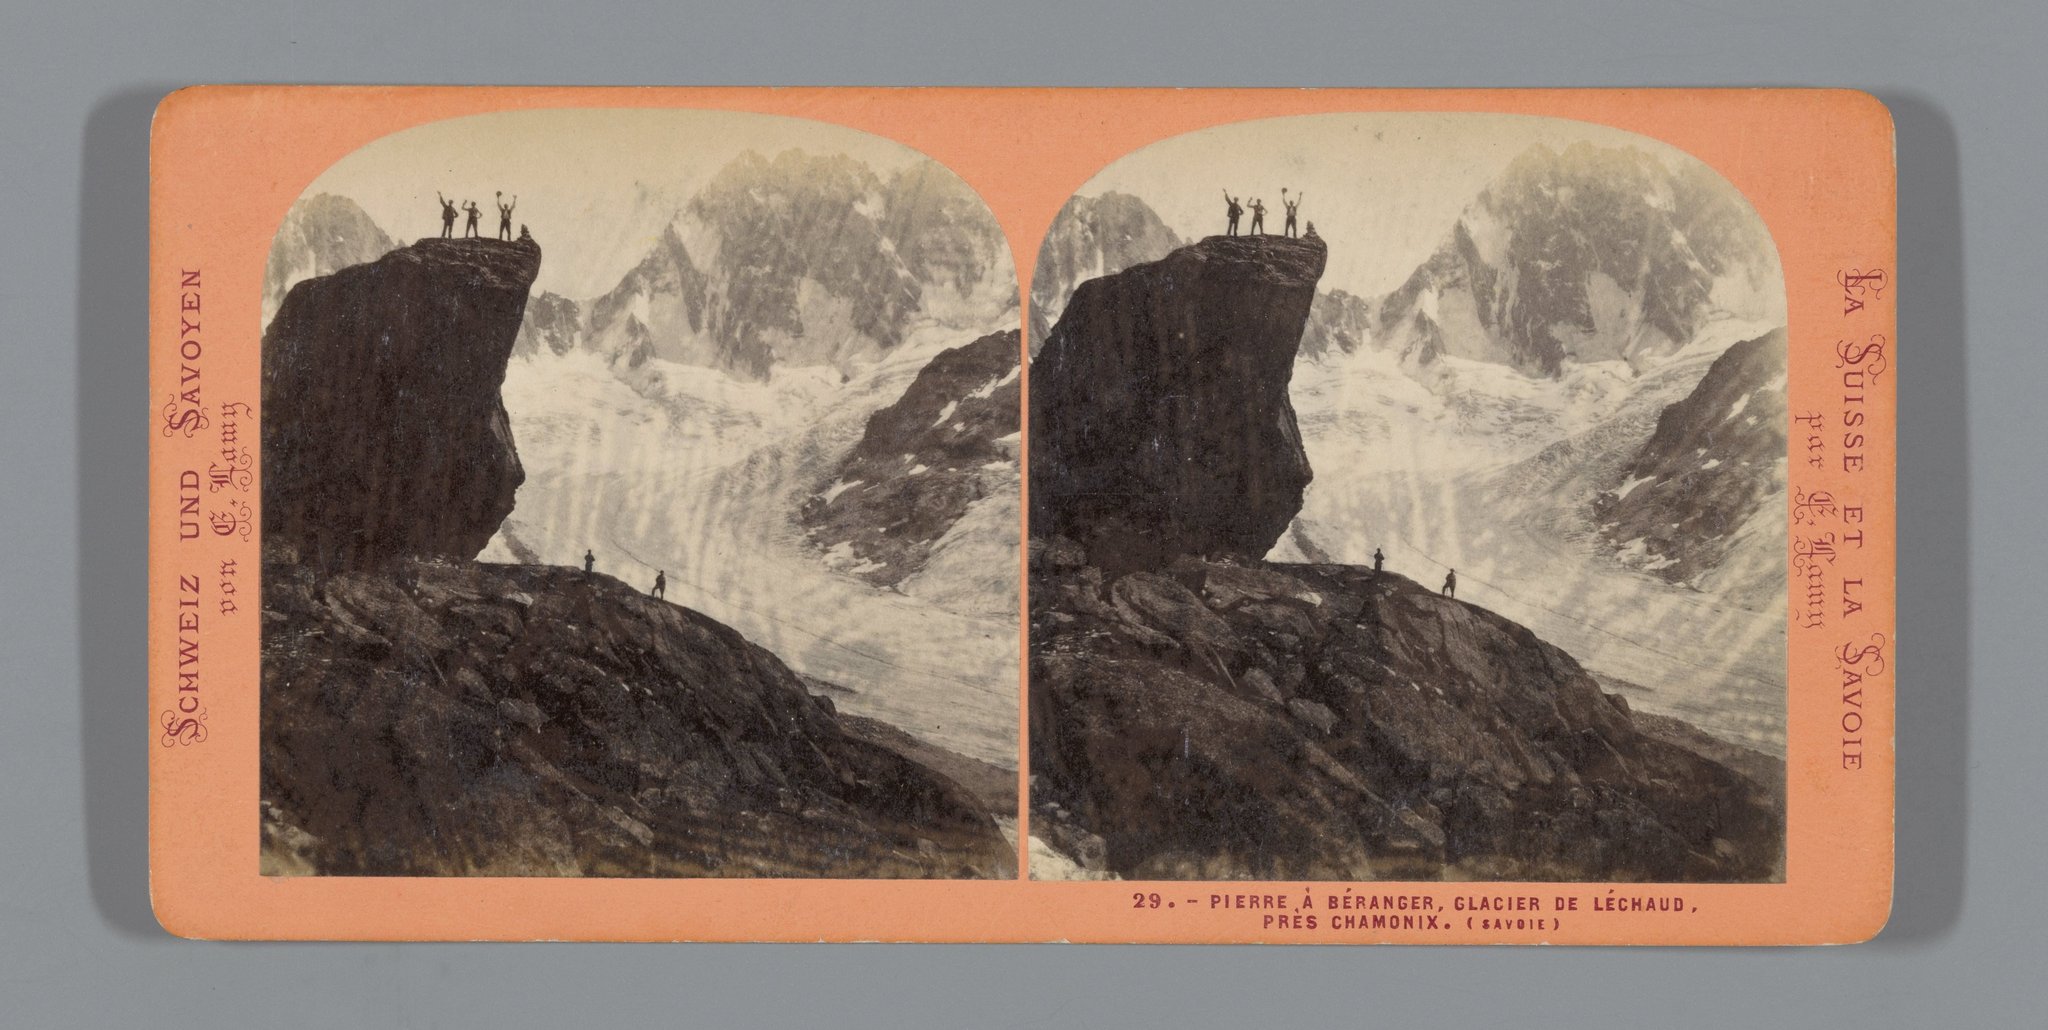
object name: stereograph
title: La Suisse et la Savoie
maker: ernest eléonor pierre lamy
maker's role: publisher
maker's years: 1828-1900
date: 1860-1880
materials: cardboard, photographic support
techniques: albumen print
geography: savoie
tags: glacier, rock-formations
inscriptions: number: ‘29.’